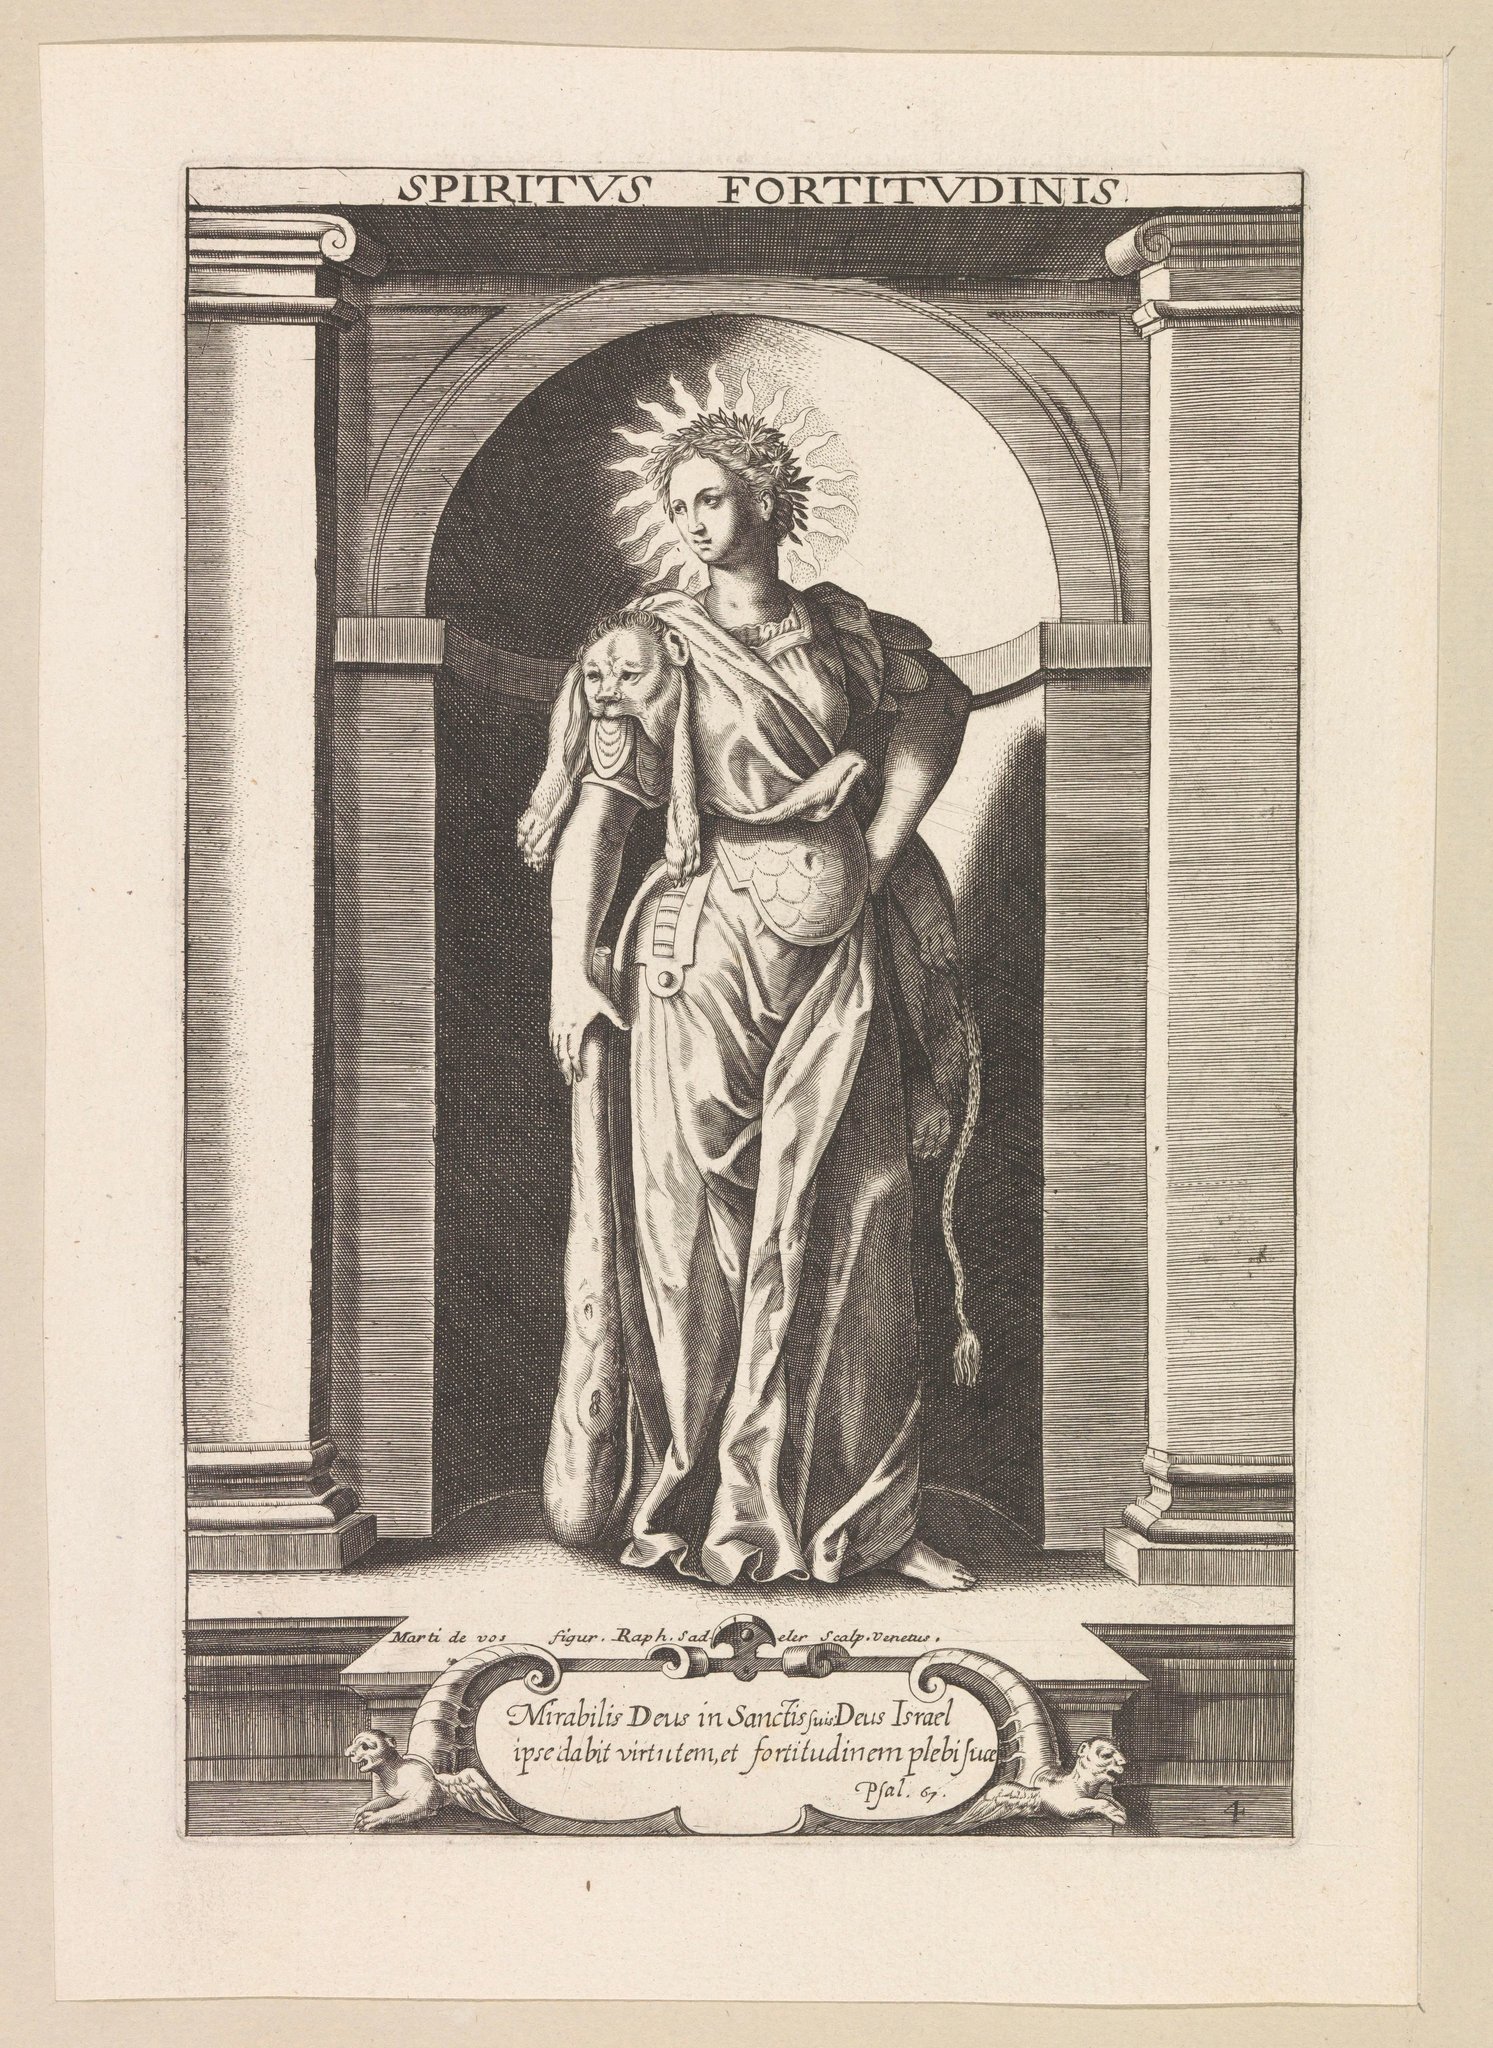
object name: print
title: Zeven gaven van de Heilige Geest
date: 1598-1604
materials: paper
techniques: engraving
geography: venice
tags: 'fortitudo', fortitude ~ one of the seven gifts of the holy ghost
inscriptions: collector's mark: Lugt 240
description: In een nis de vrouwelijke personificatie van de gave van kracht, een van de zeven gaven van de Heilige Geest. Ze draagt een kroon van bladeren en is gekleed in een leeuwenvel. In haar rechterhand heeft ze een knots. Rond haar hoofd een stralende zon.